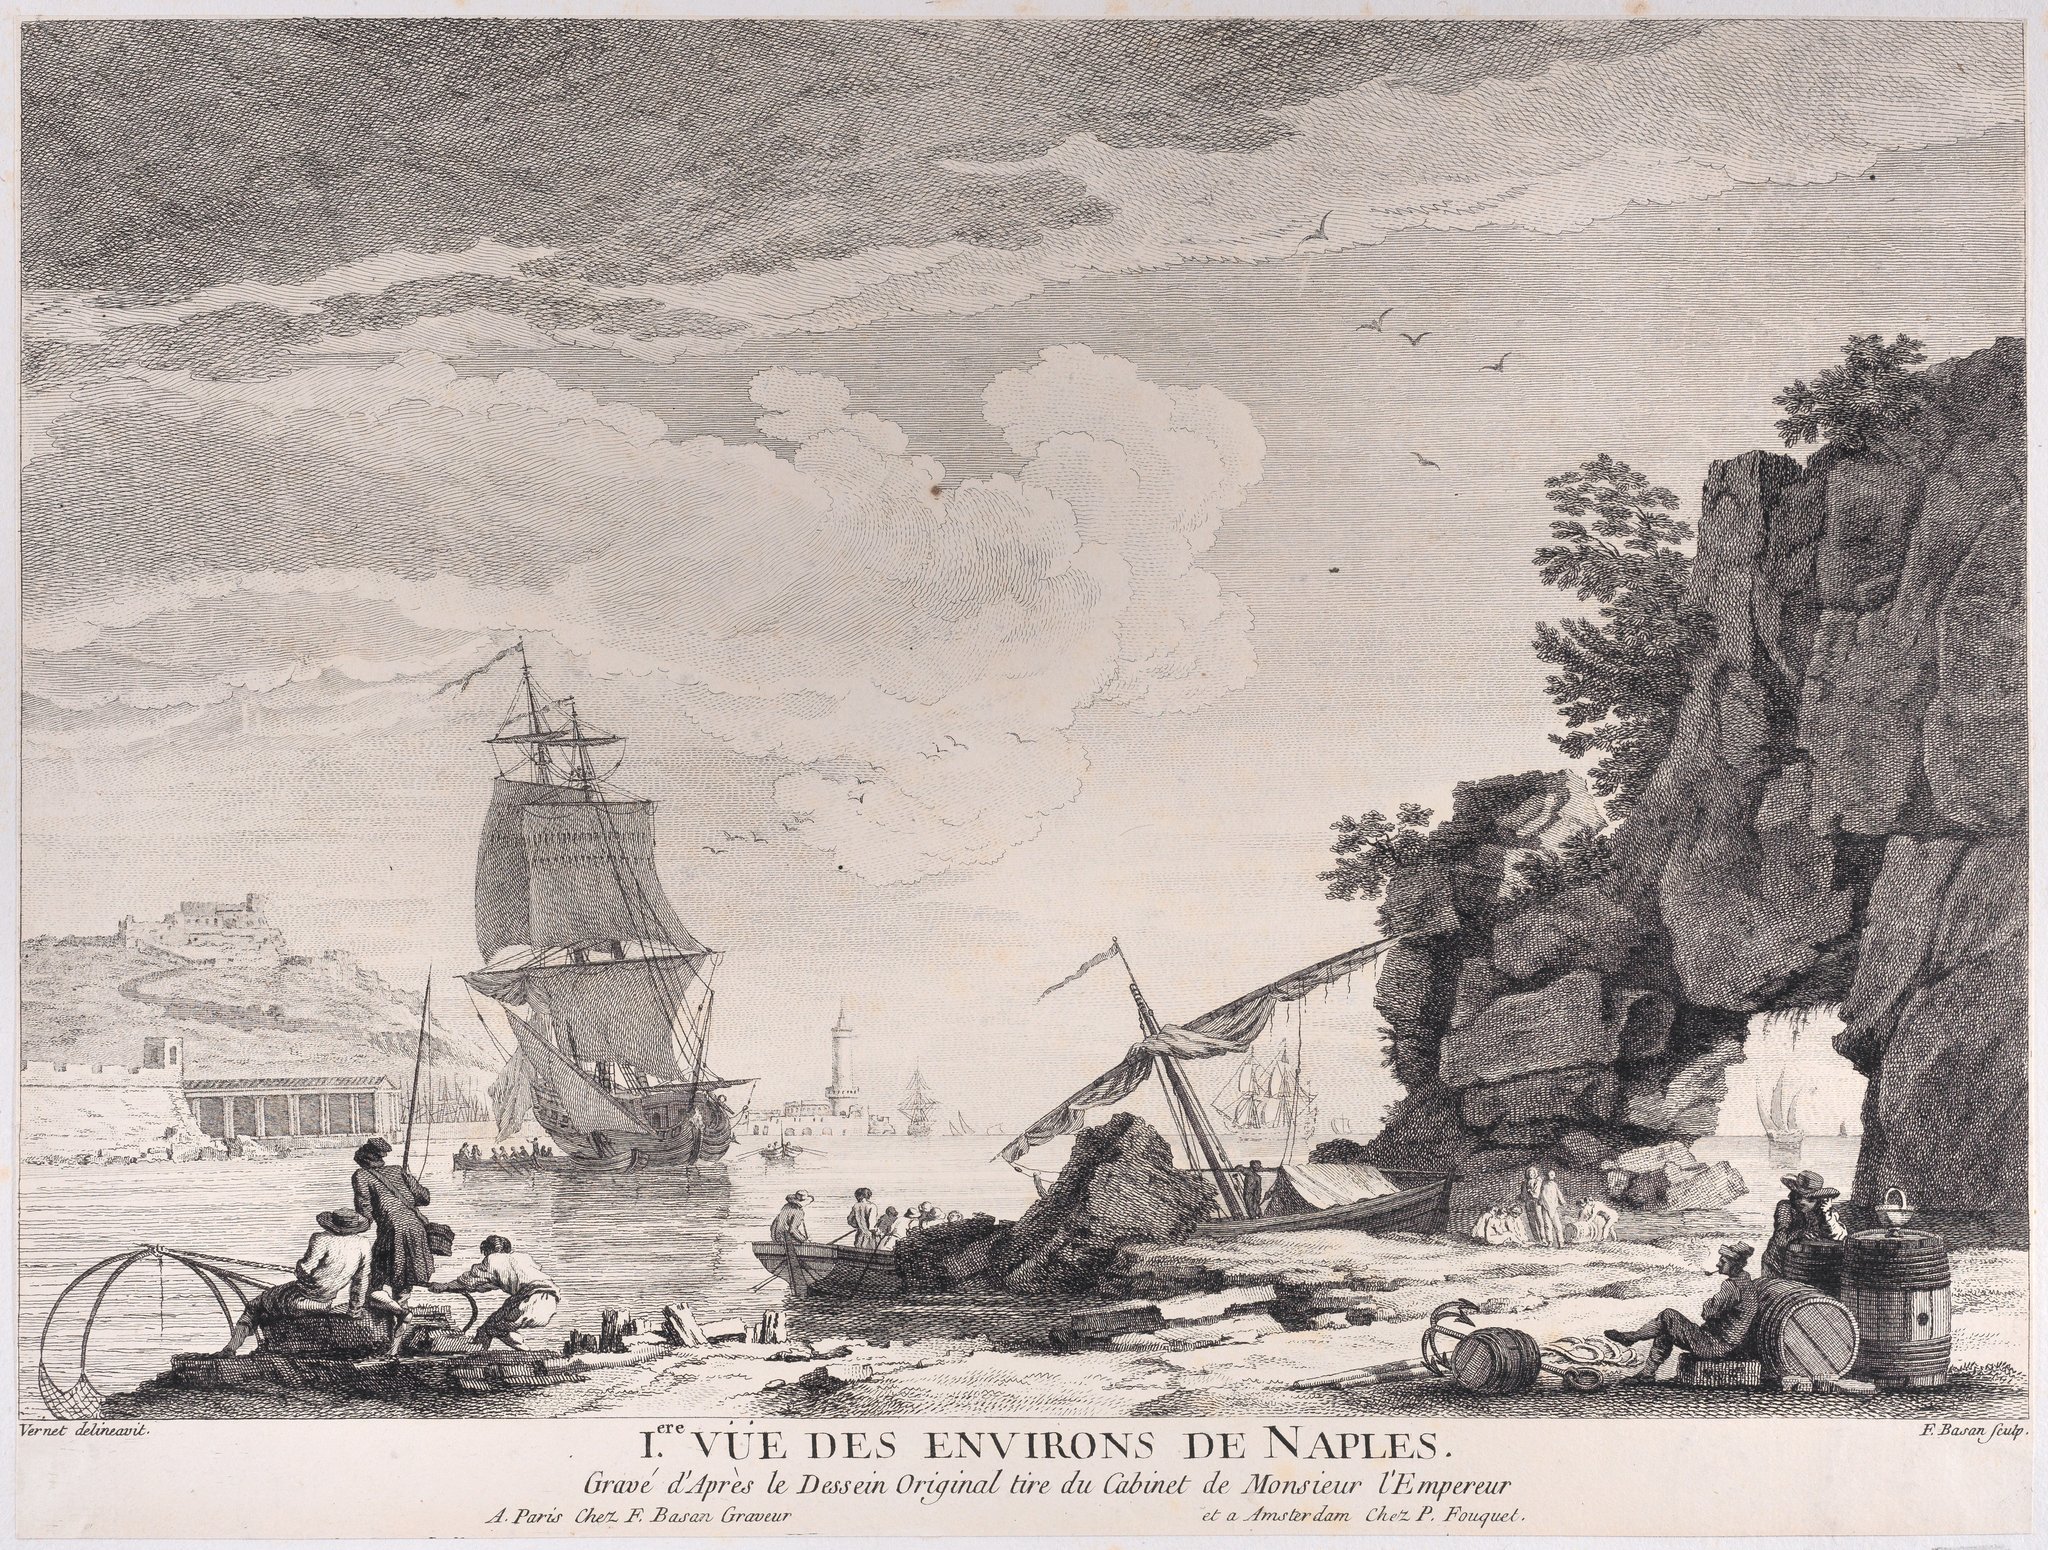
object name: print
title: First View of the Surroundings of Naples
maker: joseph vernet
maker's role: artist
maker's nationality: french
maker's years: 1714-1789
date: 1776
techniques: engraving